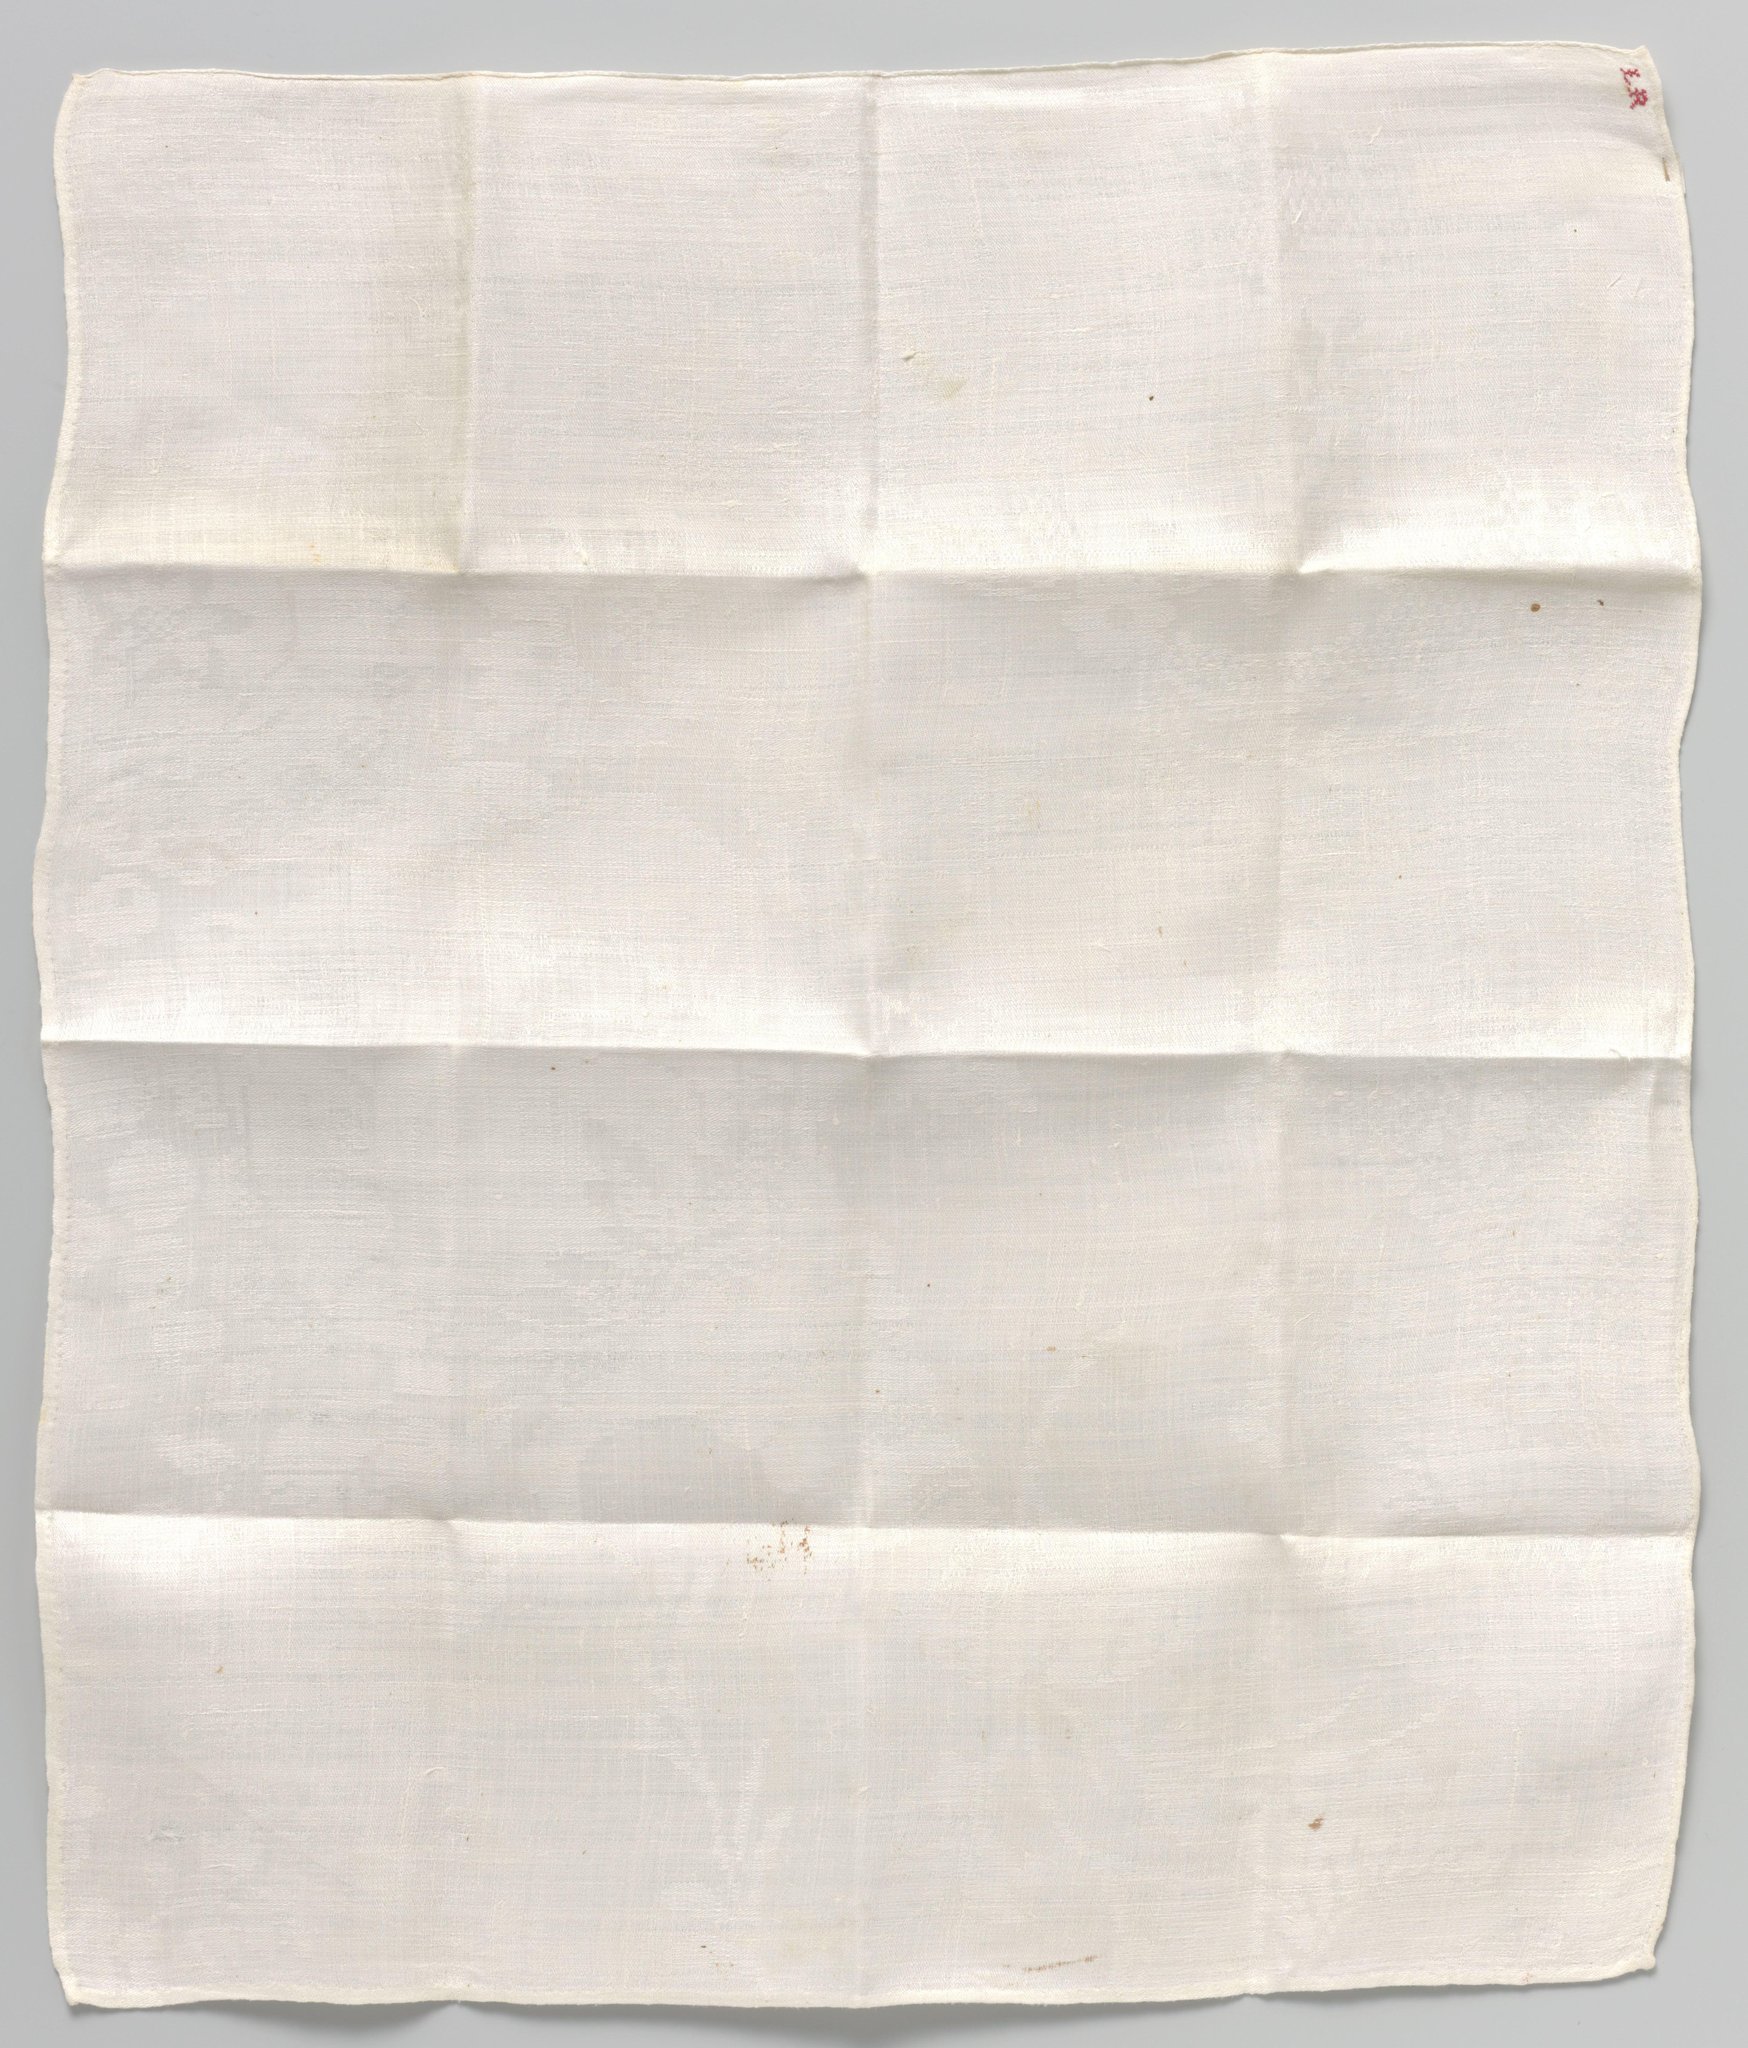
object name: napkin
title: Wit servet van damast met bloemenpatroon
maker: Anonymous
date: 1800-1930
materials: textile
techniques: damask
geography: europe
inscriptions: monogram: ‘LR’